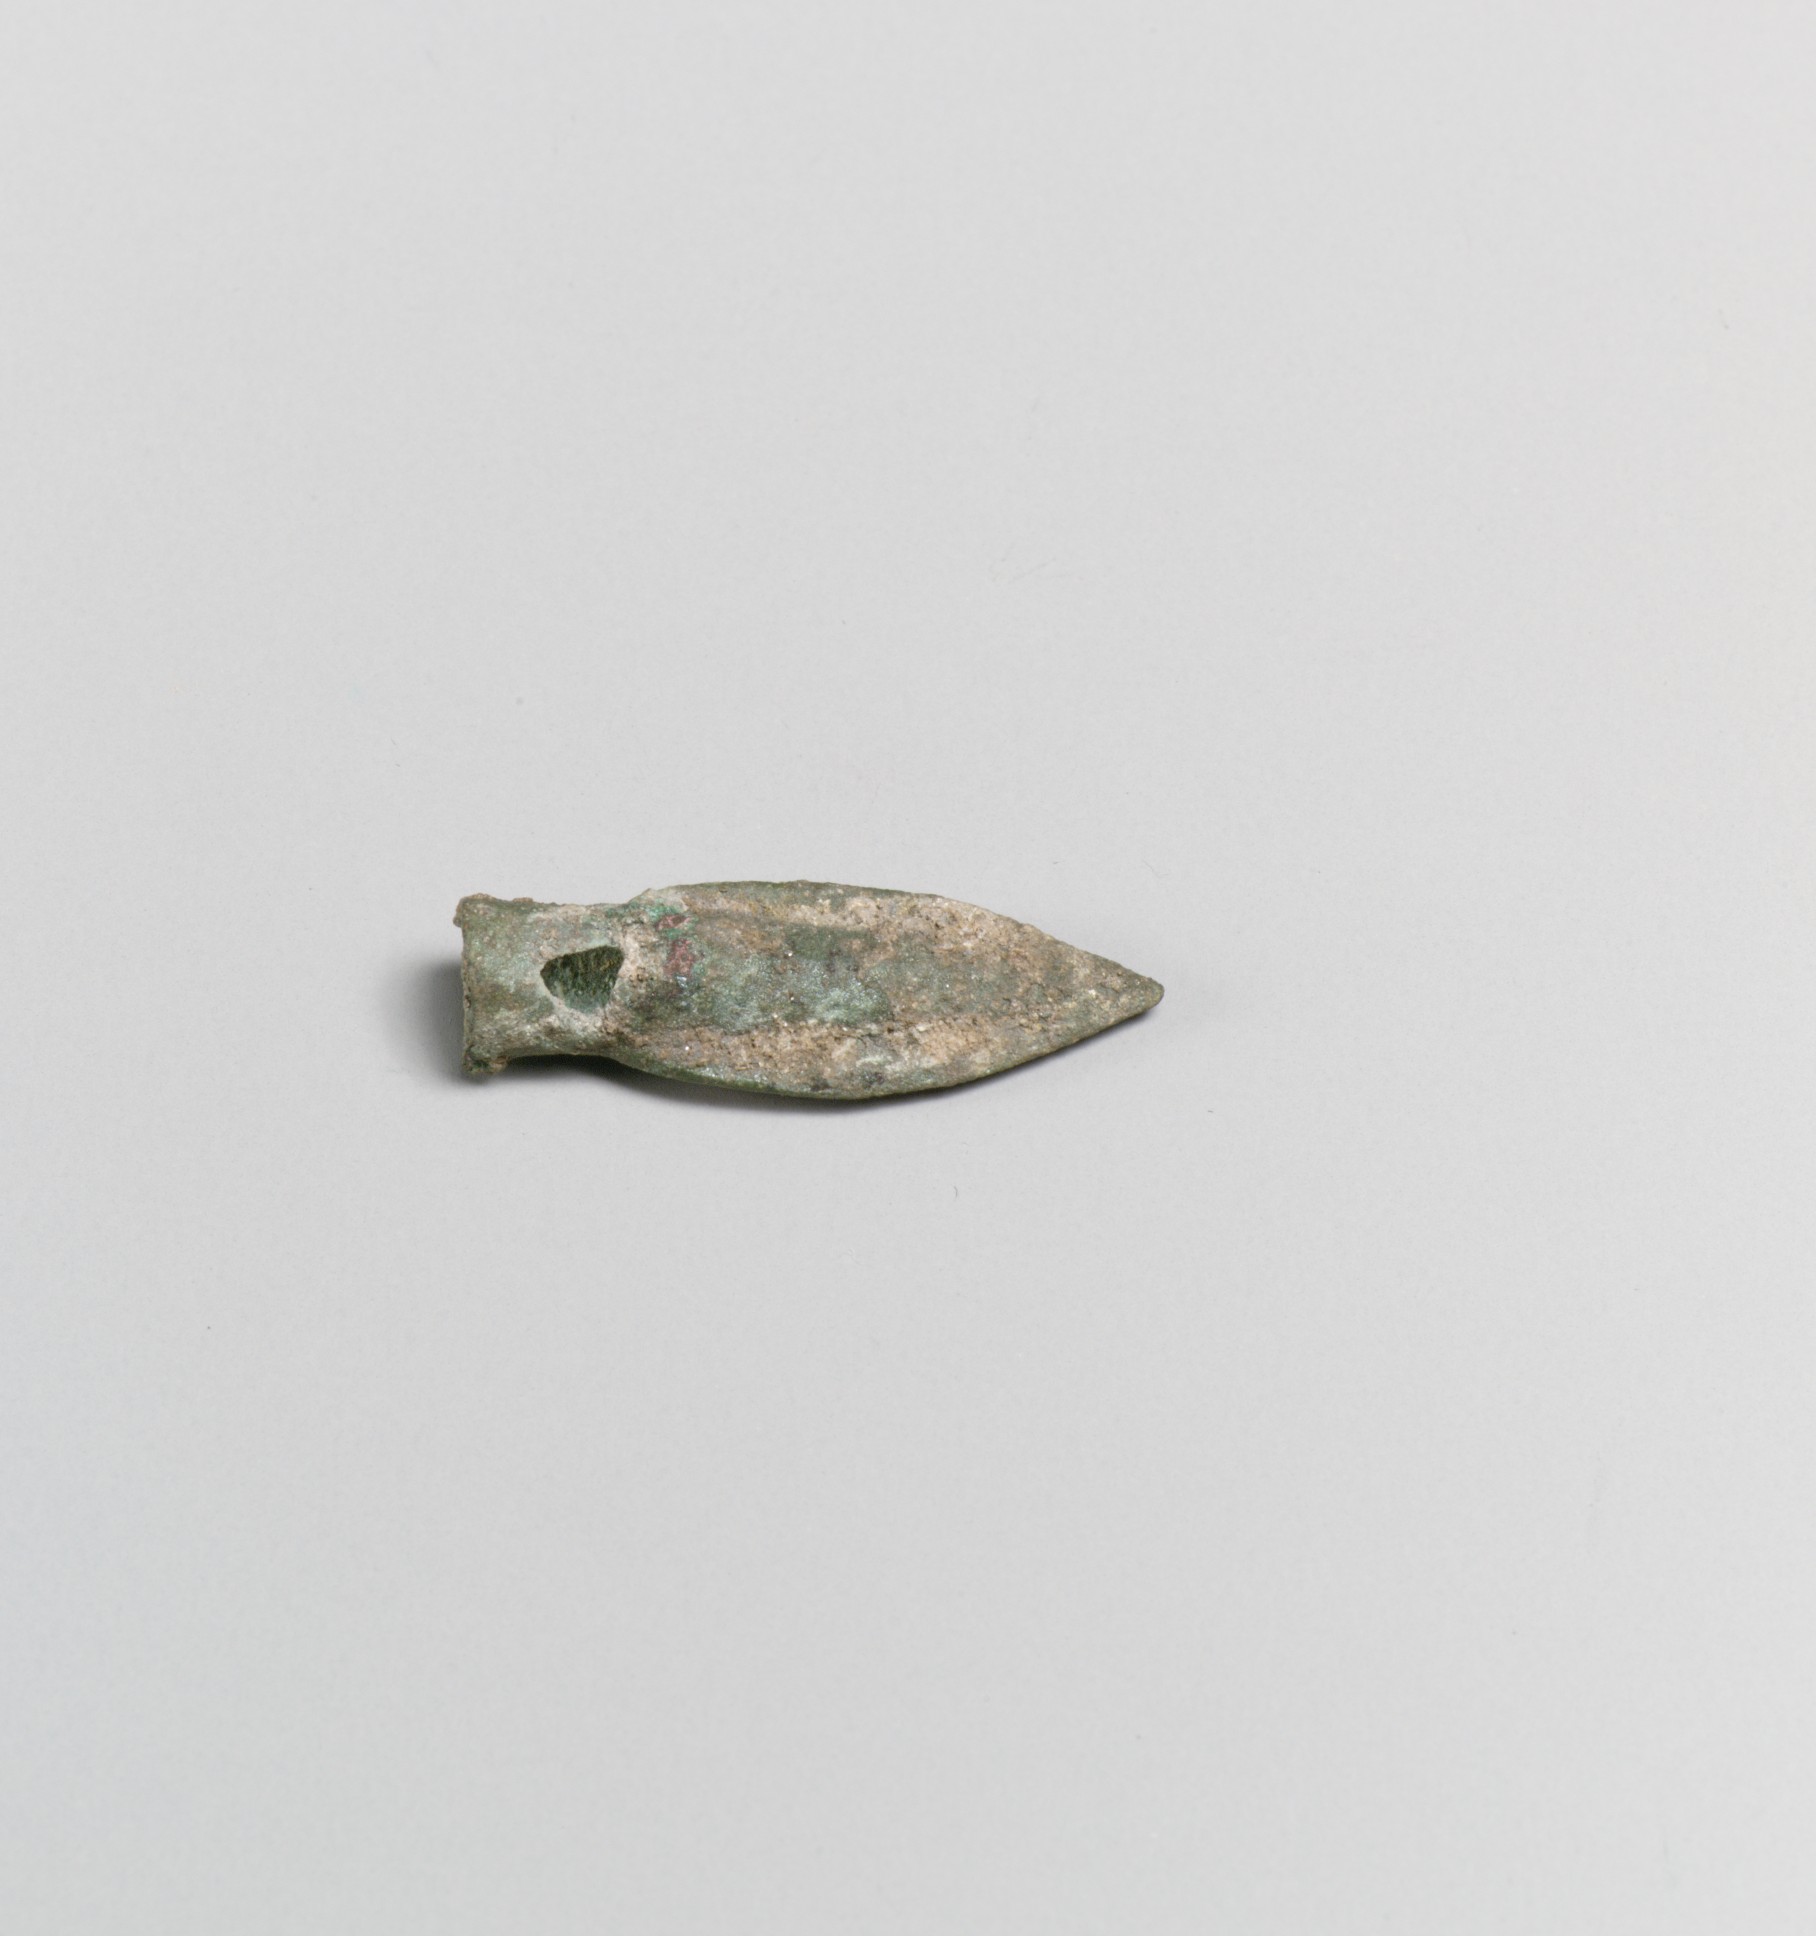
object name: arrowhead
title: Bronze arrowhead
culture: achaemenid or greek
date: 400-501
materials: bronze